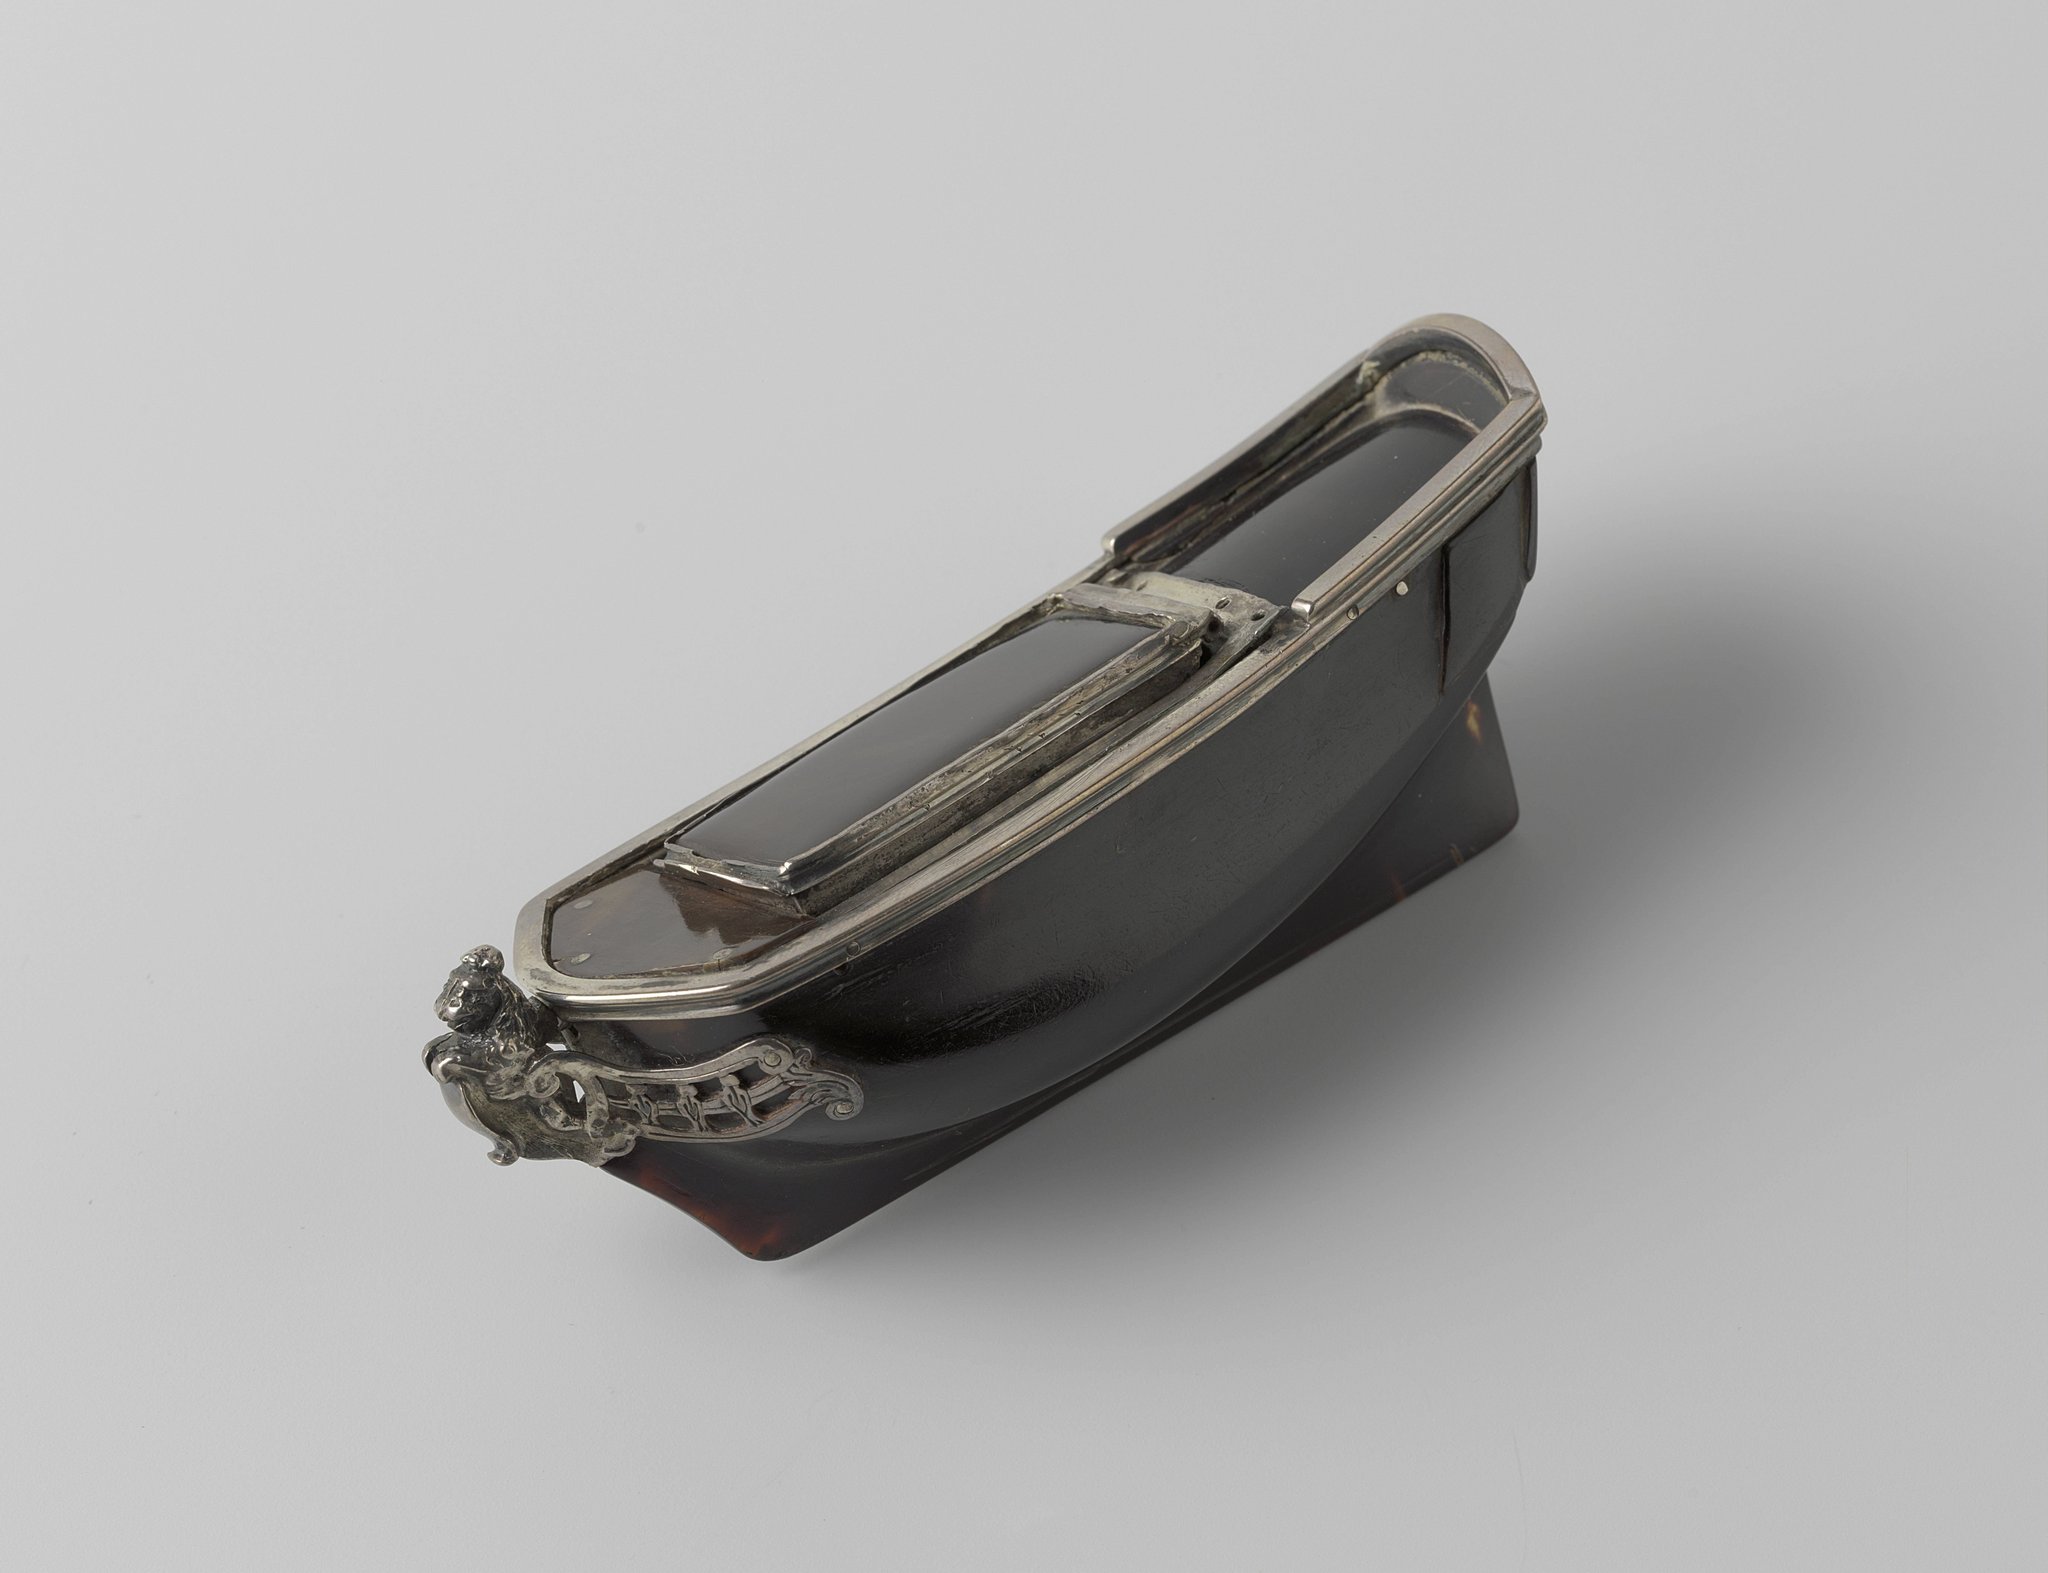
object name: box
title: Doos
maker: Anonymous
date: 1740-1760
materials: silver, shell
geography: netherlands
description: Doos van schildpad in de vorm van een boot met zilver gemonteerd. Op de voorsteven een leeuw.